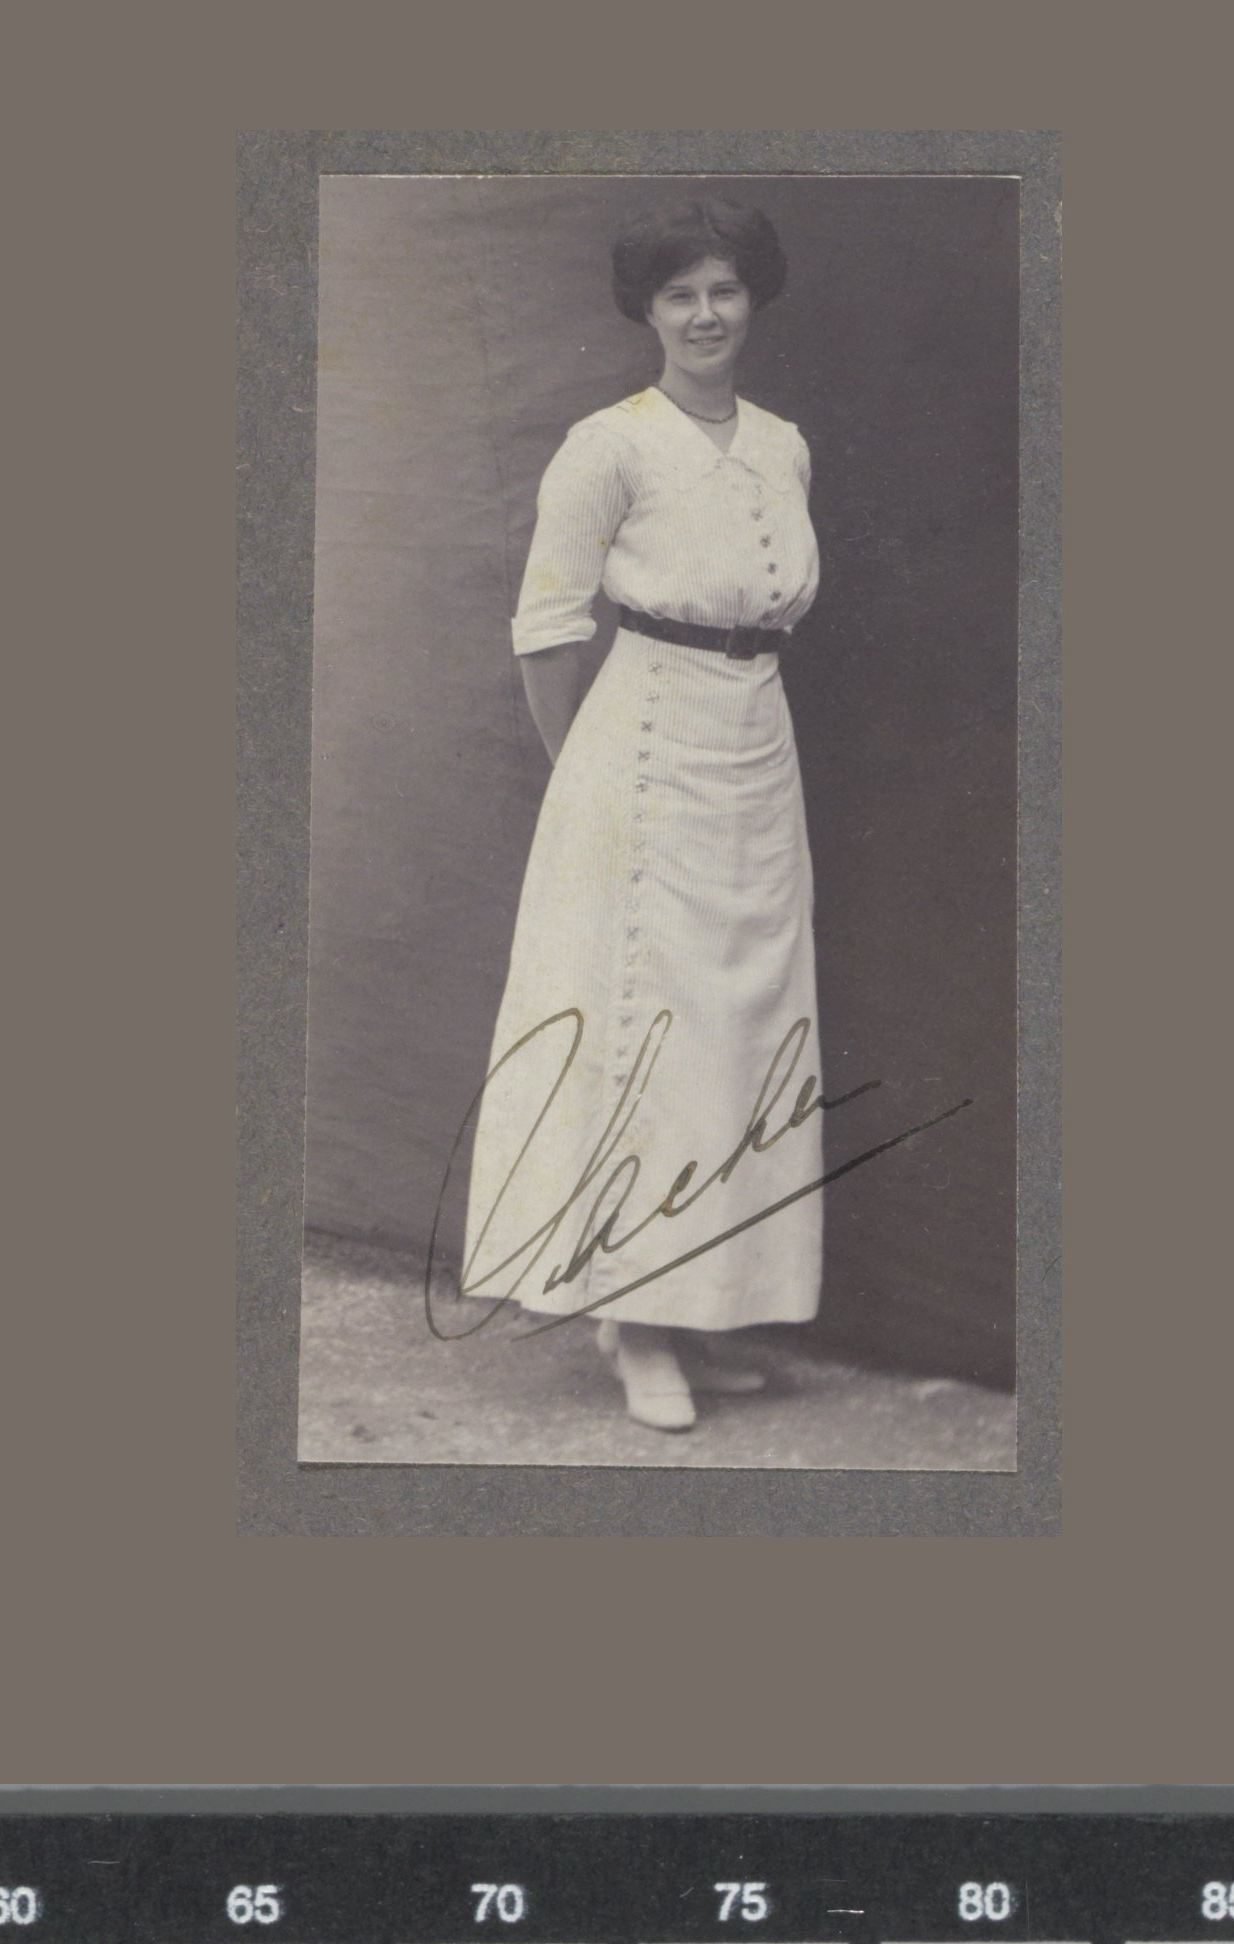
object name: photograph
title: Sacha Croese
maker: Anonymous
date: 1912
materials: photographic support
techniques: photography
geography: suriname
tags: suriname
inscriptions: inscription: ‘Sacha’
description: Portret van Sacha Croese, staande ten voeten uit, poserend in een fotostudio. Gesigneerd door Sacha. Onderdeel van het fotoalbum over het leven van de familie Gonggrijp in Suriname rond 1912.